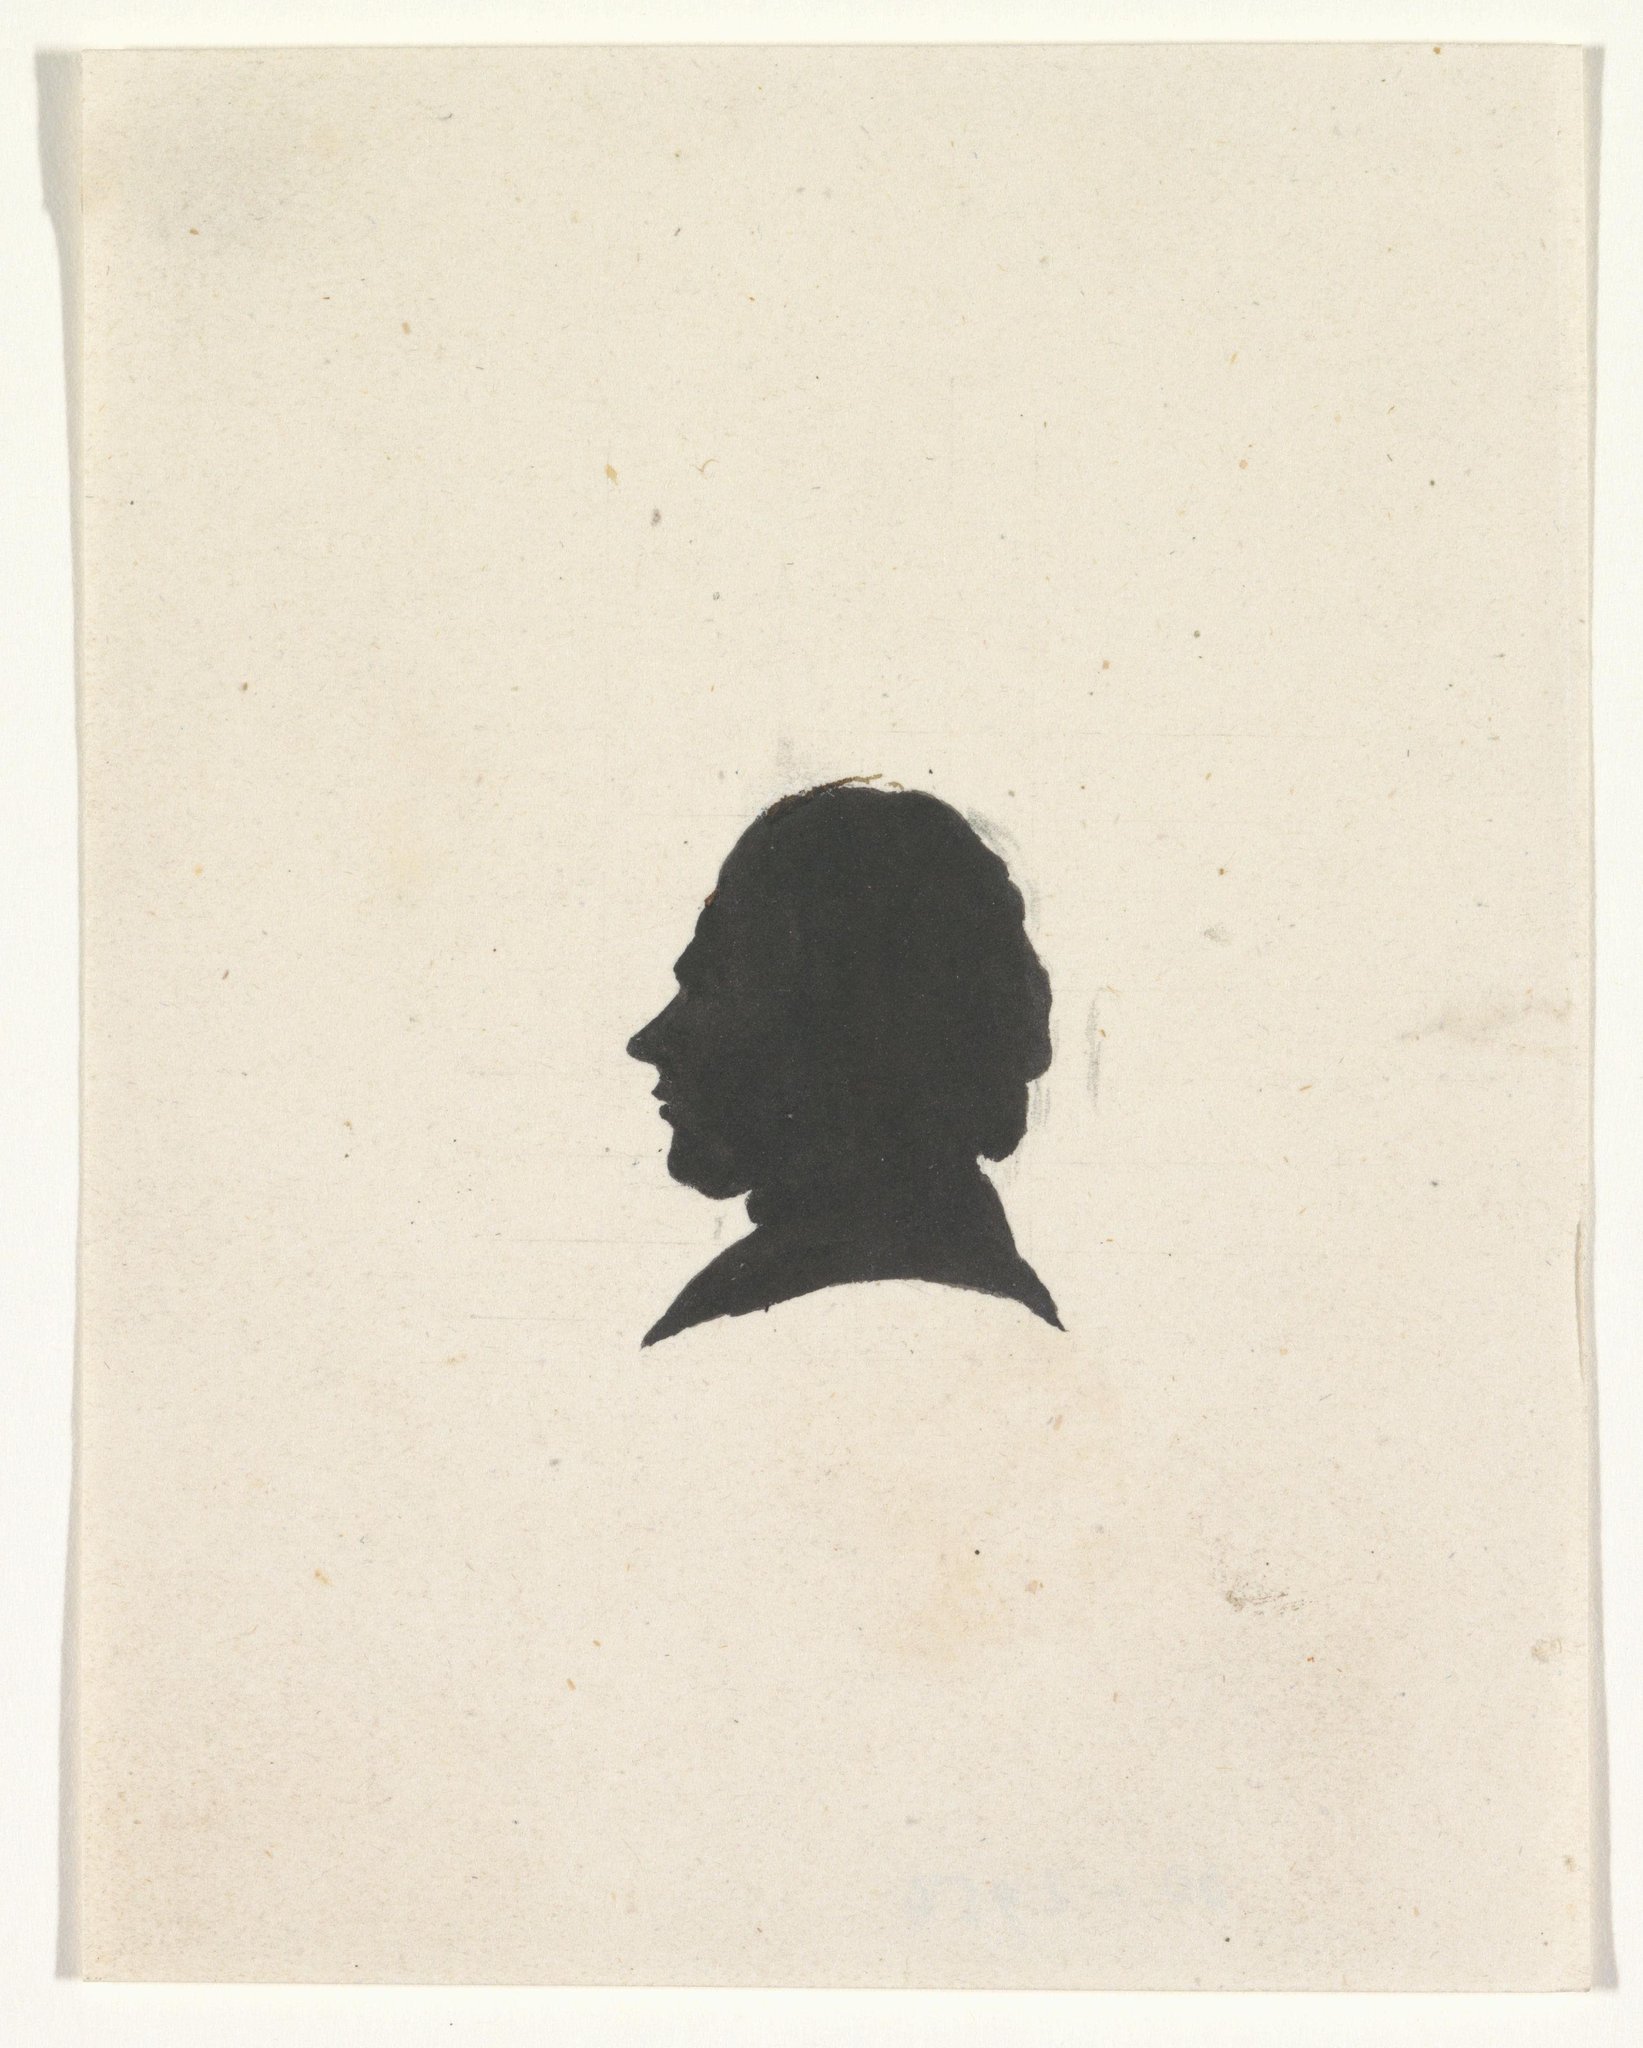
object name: drawing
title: Silhouet van een jongeman, naar links kijkend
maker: Anonymous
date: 1700-1900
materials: ink, paper, pencil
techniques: brush, pen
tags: anonymous historical person portrayed alone, male sex; man